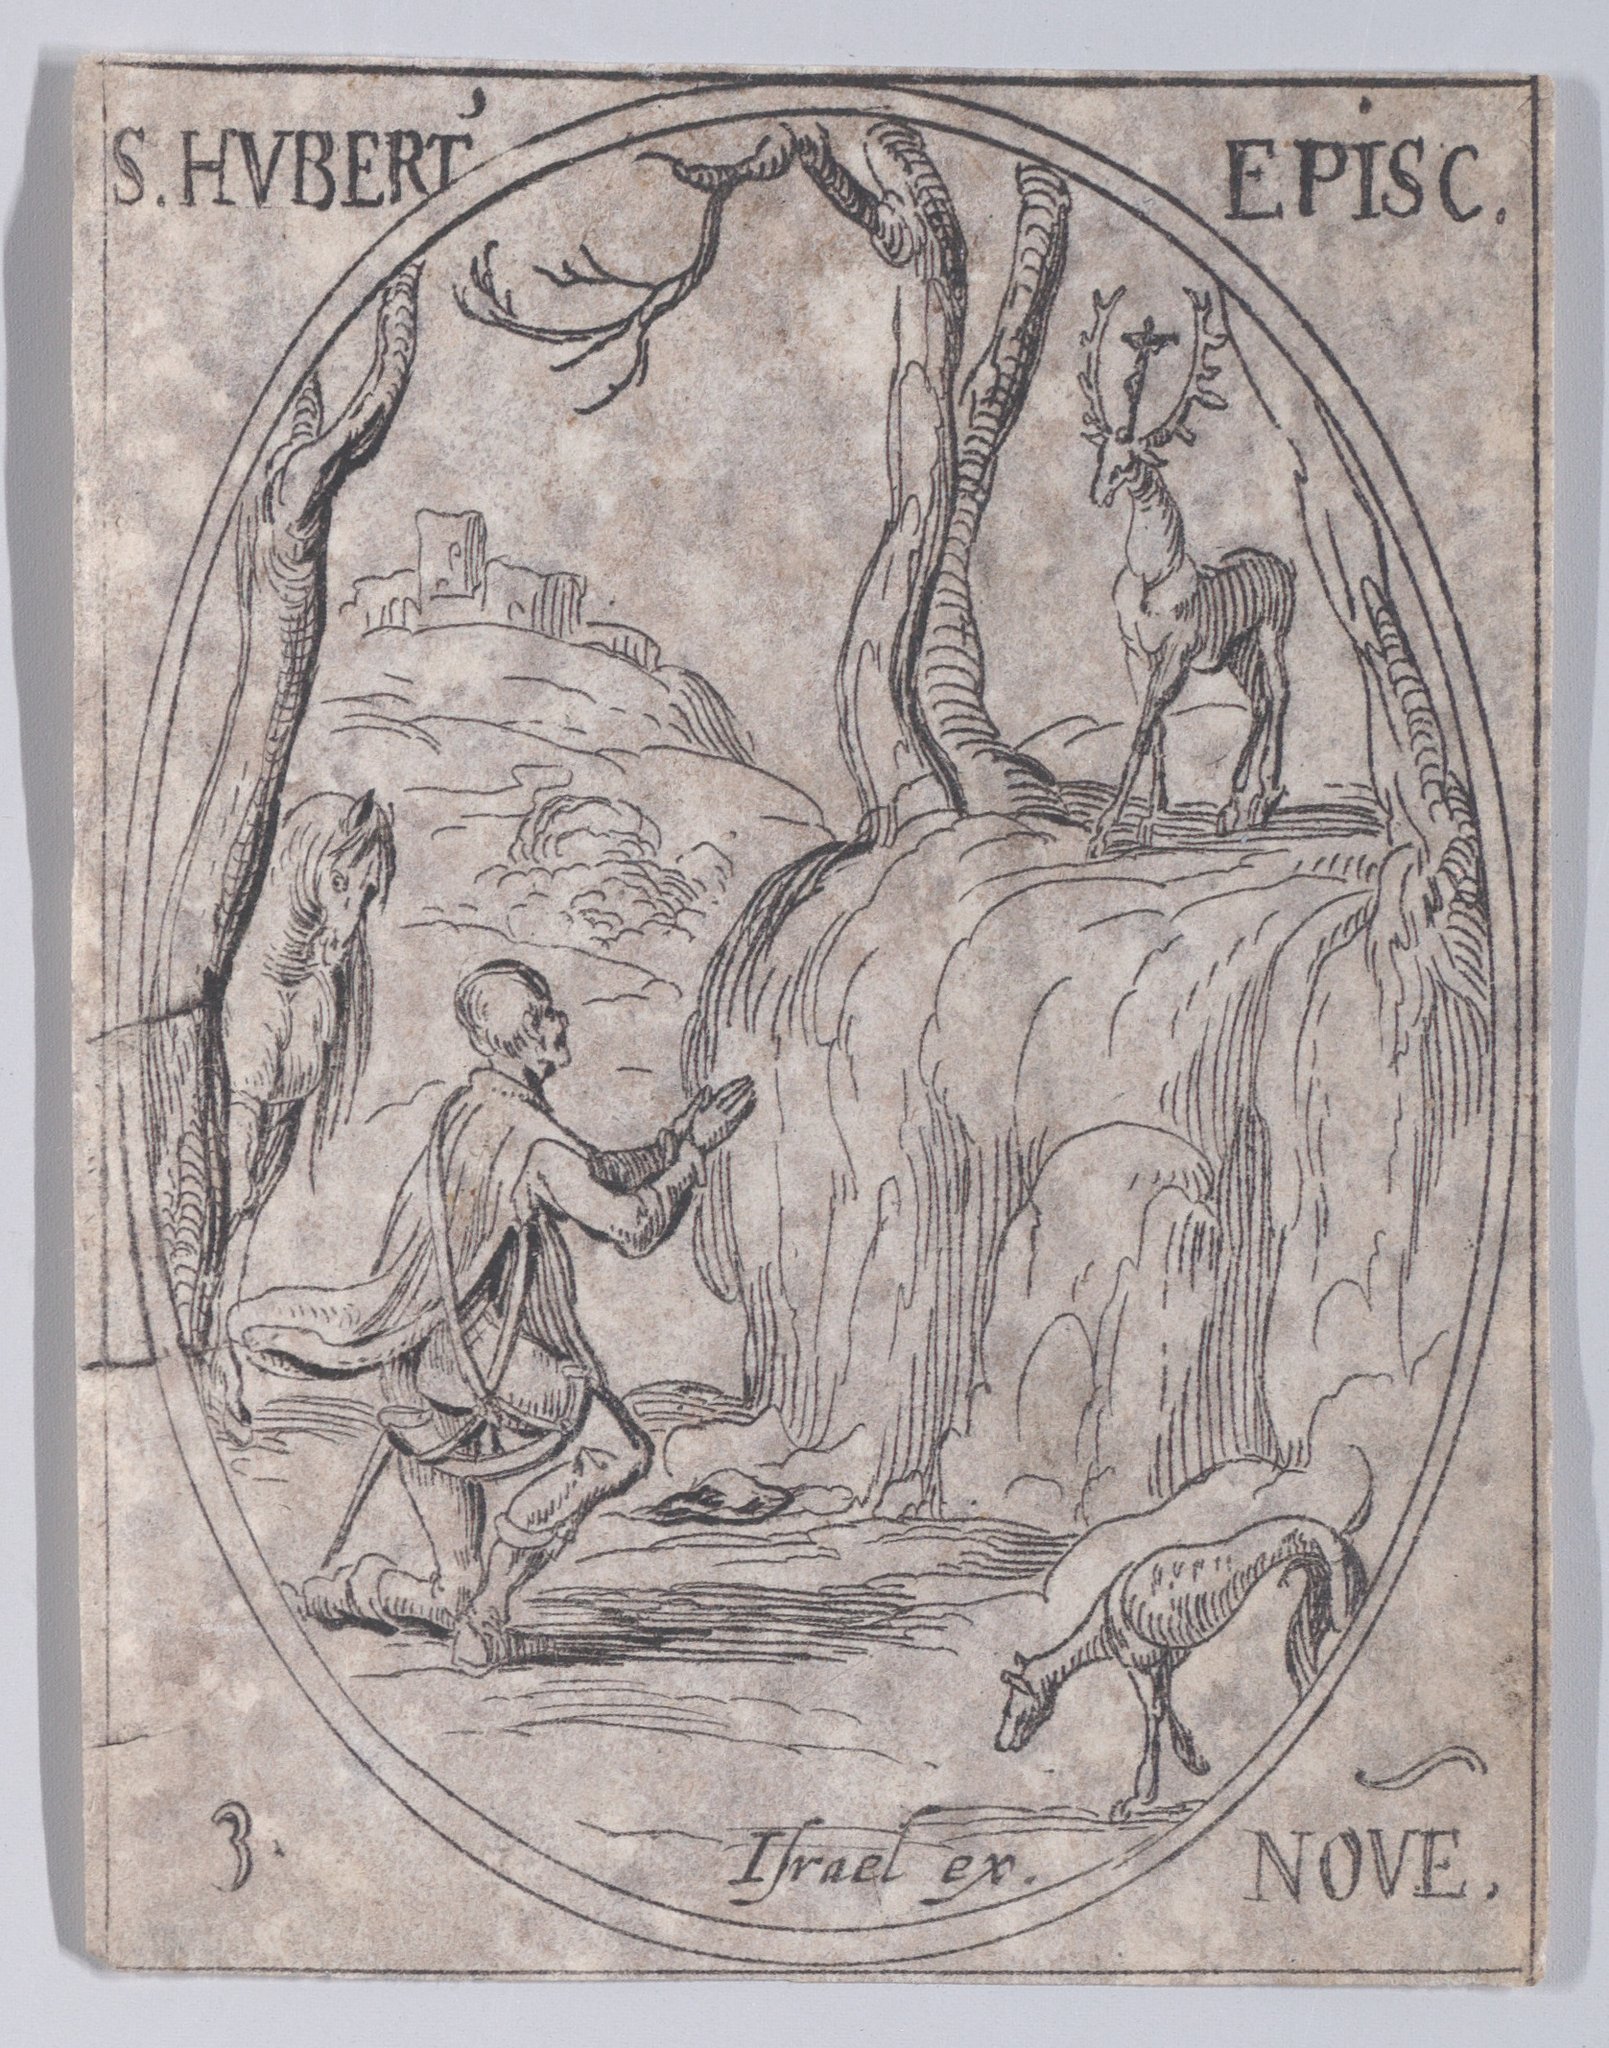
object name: print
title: S. Hubert, évêque (St. Hubert, Bishop), from November 3rd, from "Les Images De Tous Les Saincts et Saintes de L'Année" (Images of All of the Saints and Religious Events of the Year)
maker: jacques callot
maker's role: artist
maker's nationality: french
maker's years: 1592-1635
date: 1636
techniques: etching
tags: animals,men,saints